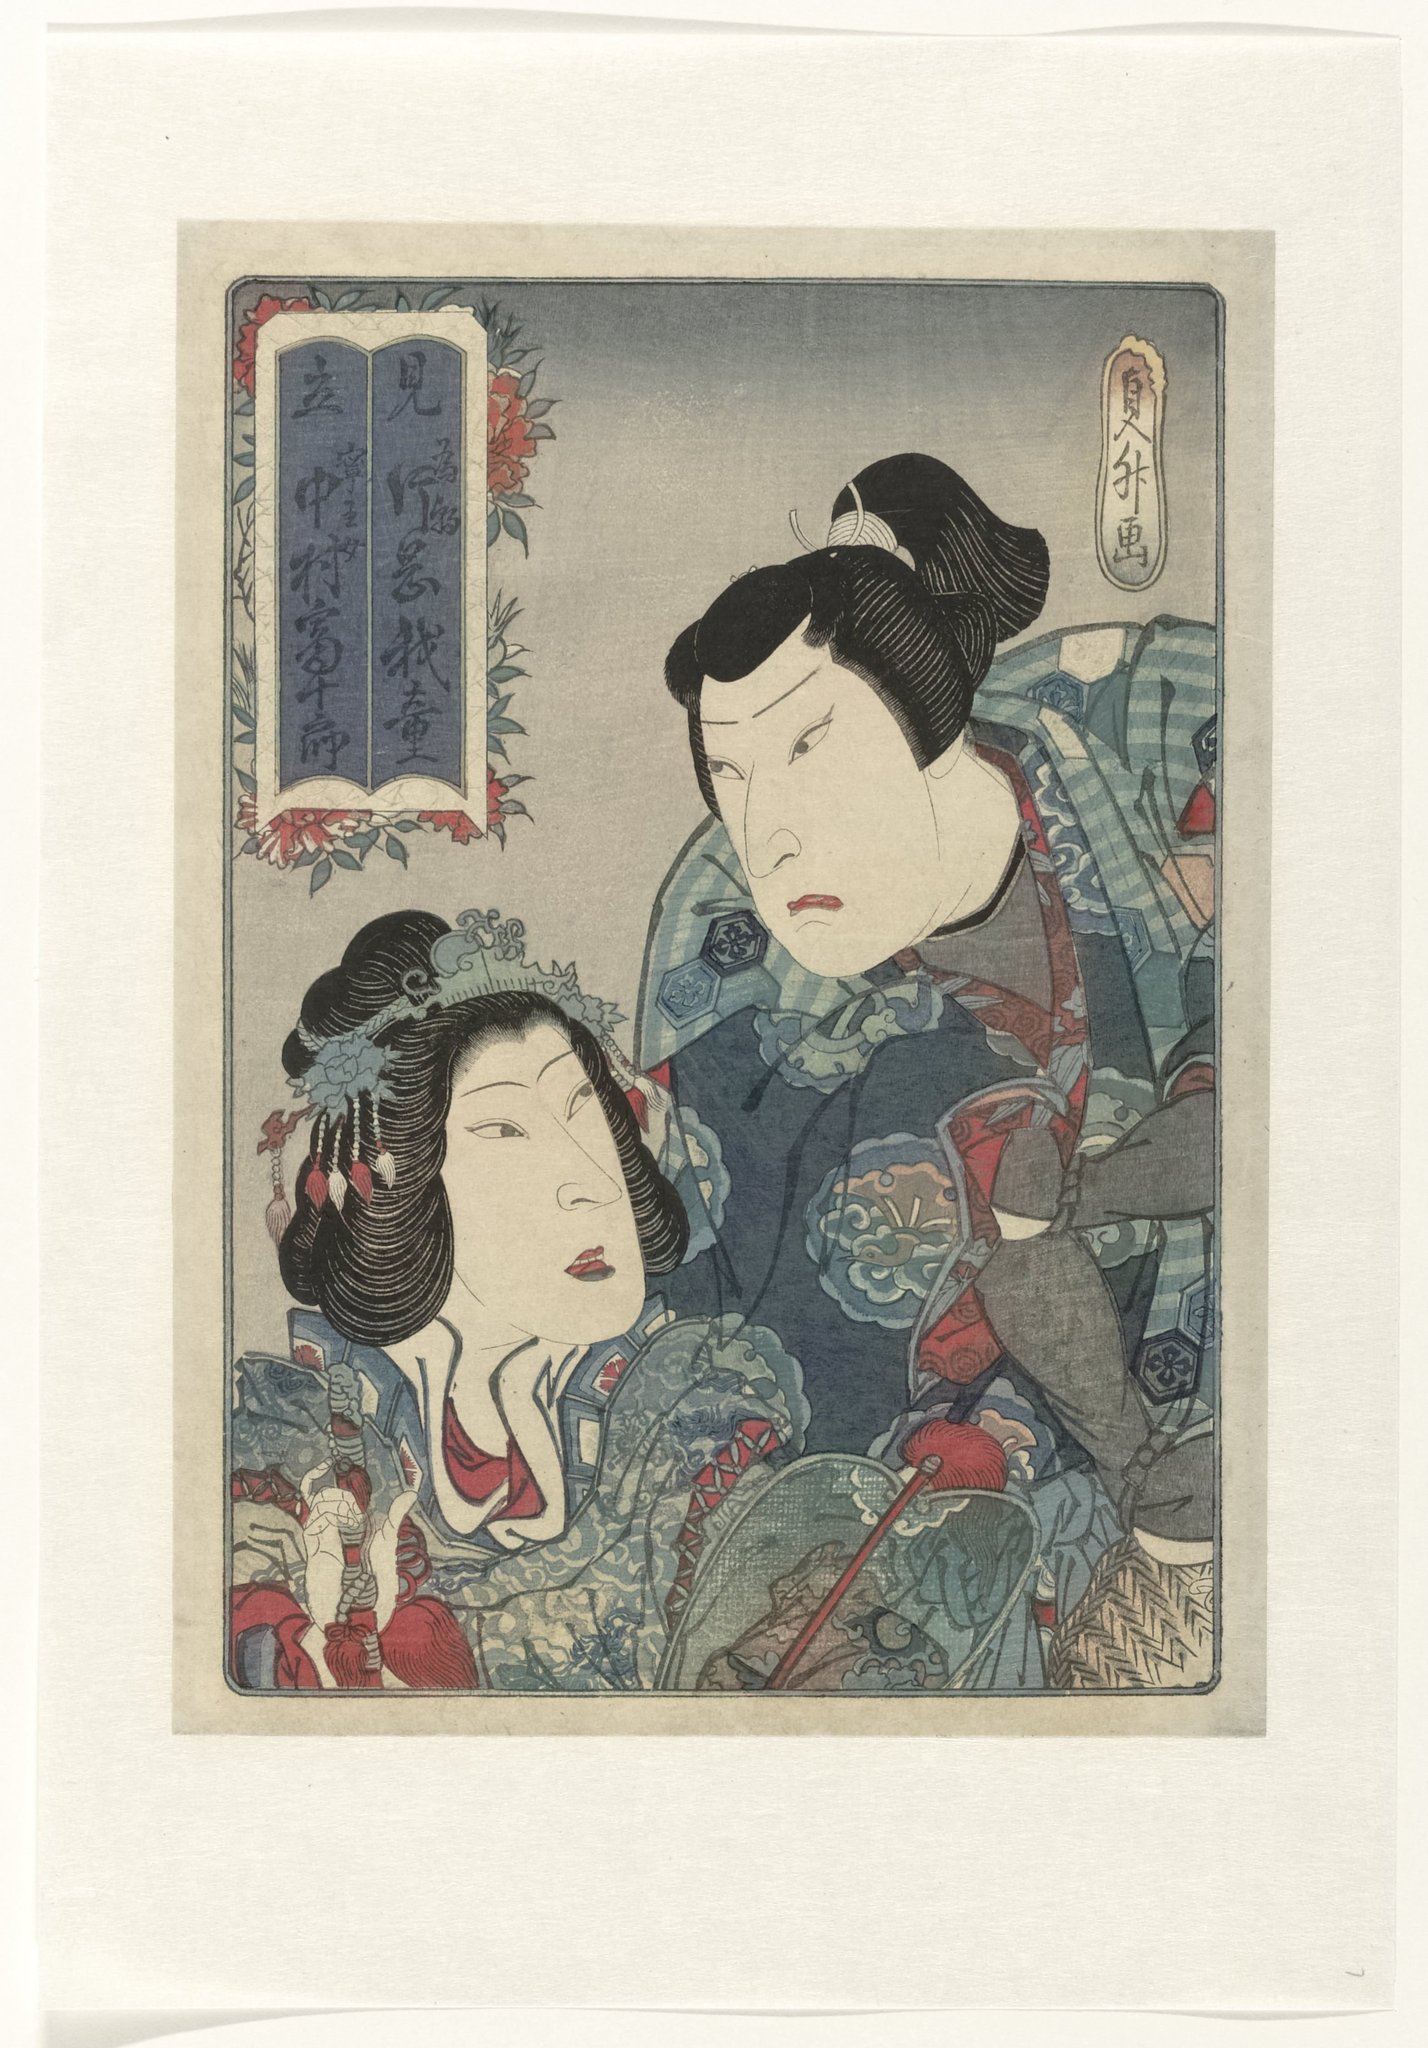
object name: print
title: Nakamura Tomijûrô II als Neiwanjo (links) en Kataoka Gadô II als Tametomo.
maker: utagawa sadamasu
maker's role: print maker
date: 1841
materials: paper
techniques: woodcut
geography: osaka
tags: portrait of actor, actress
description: Nakamura Tomijûrô II als Neiwanjo (links) en Kataoka Gadô II als Tametomo.